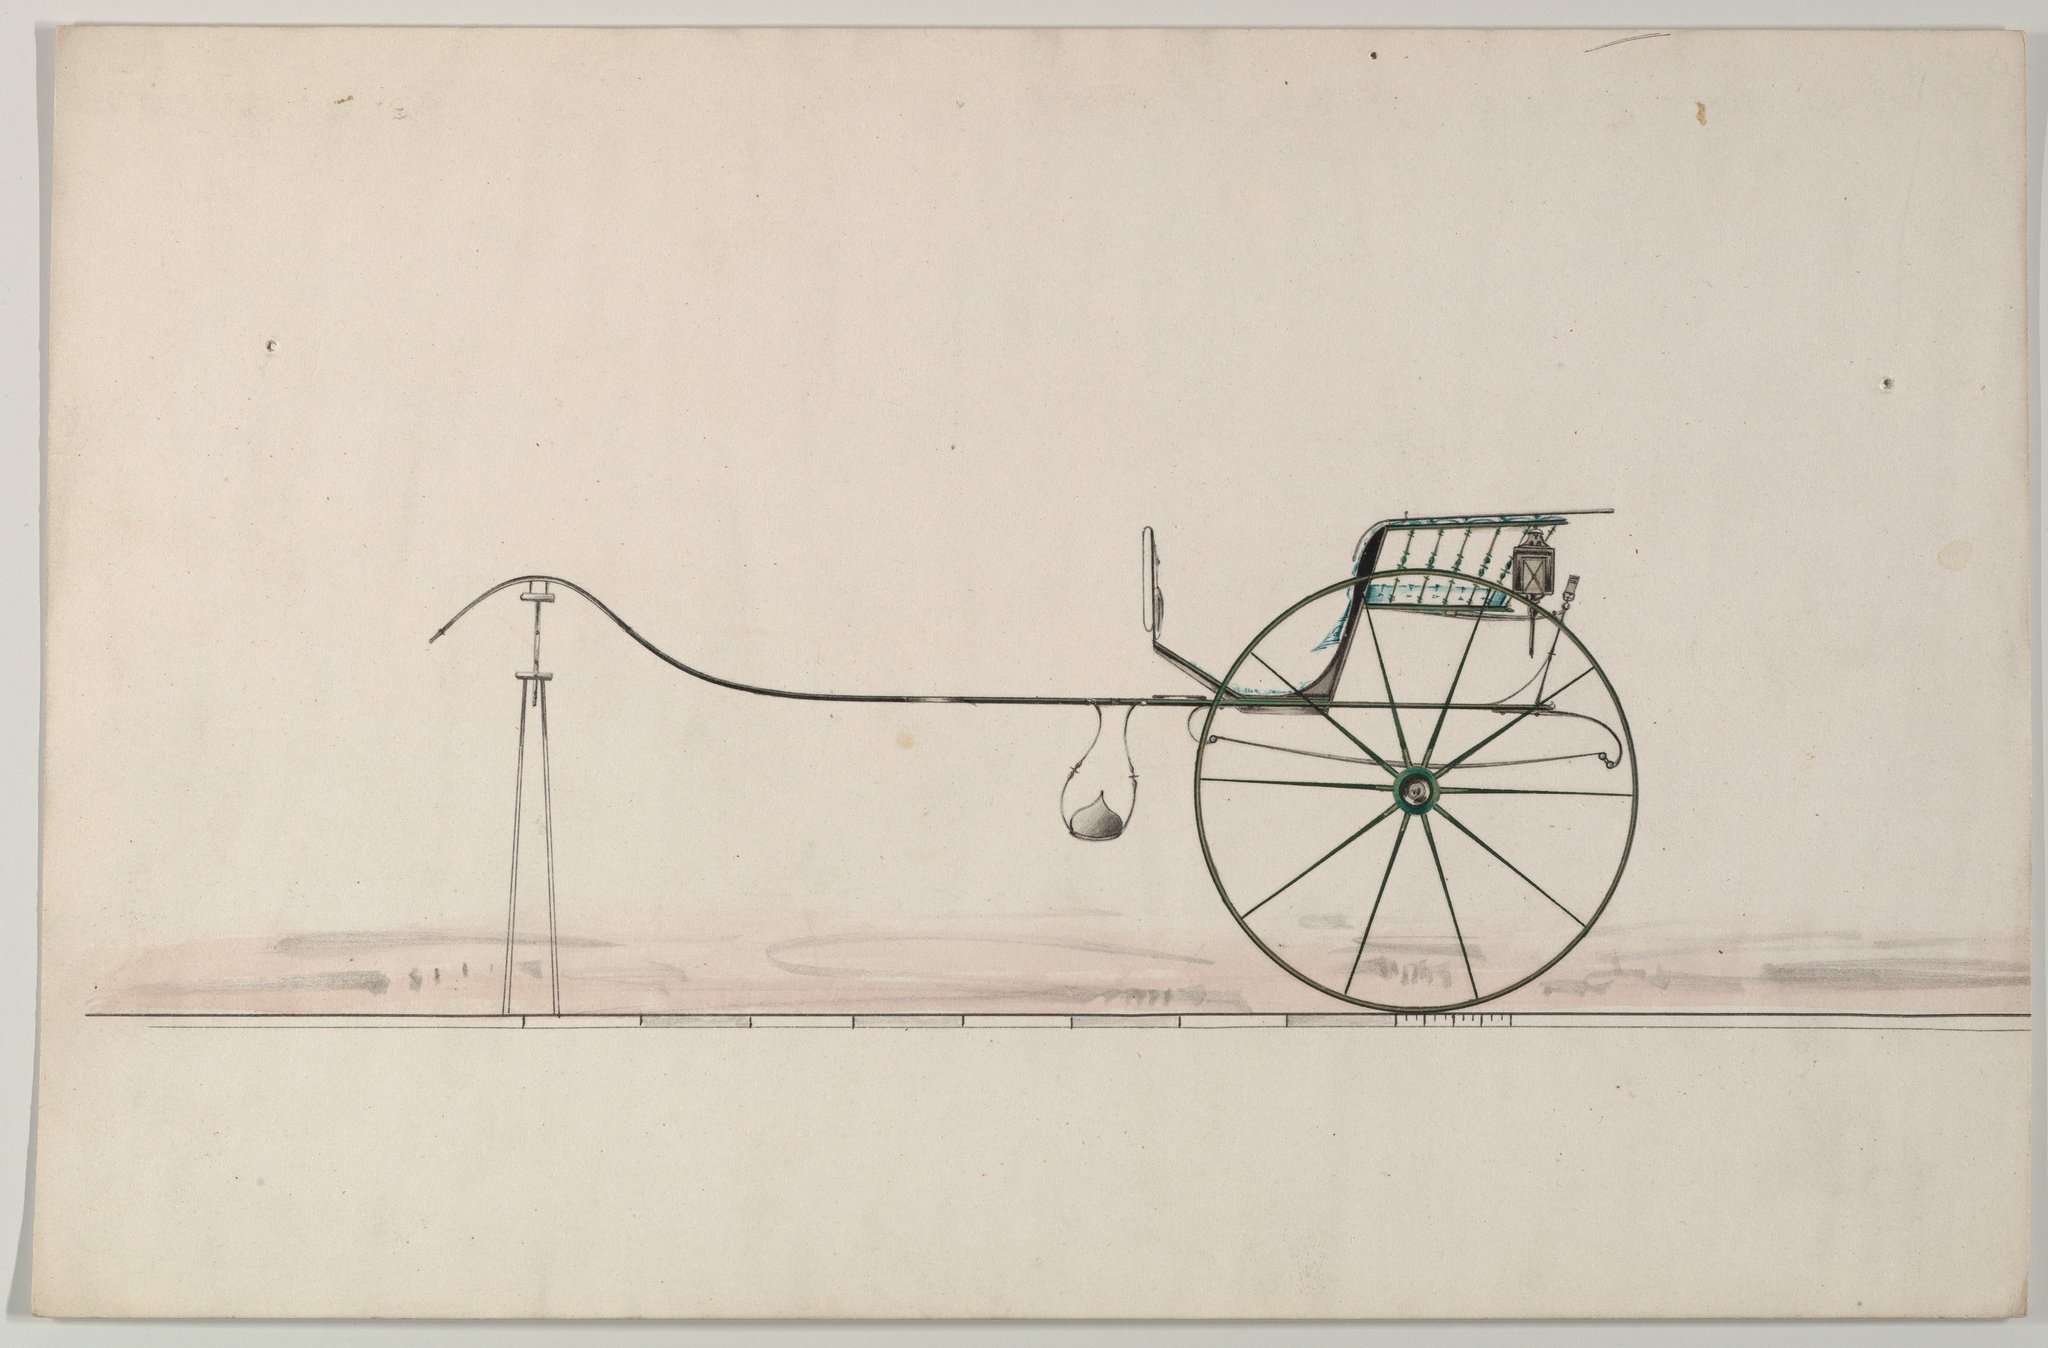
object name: drawing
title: Gig (unnumbered)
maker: brewster & co.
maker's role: manufacturer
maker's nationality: american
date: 1850-1874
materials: gouache, gum arabic, ink, watercolor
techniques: pen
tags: carriages